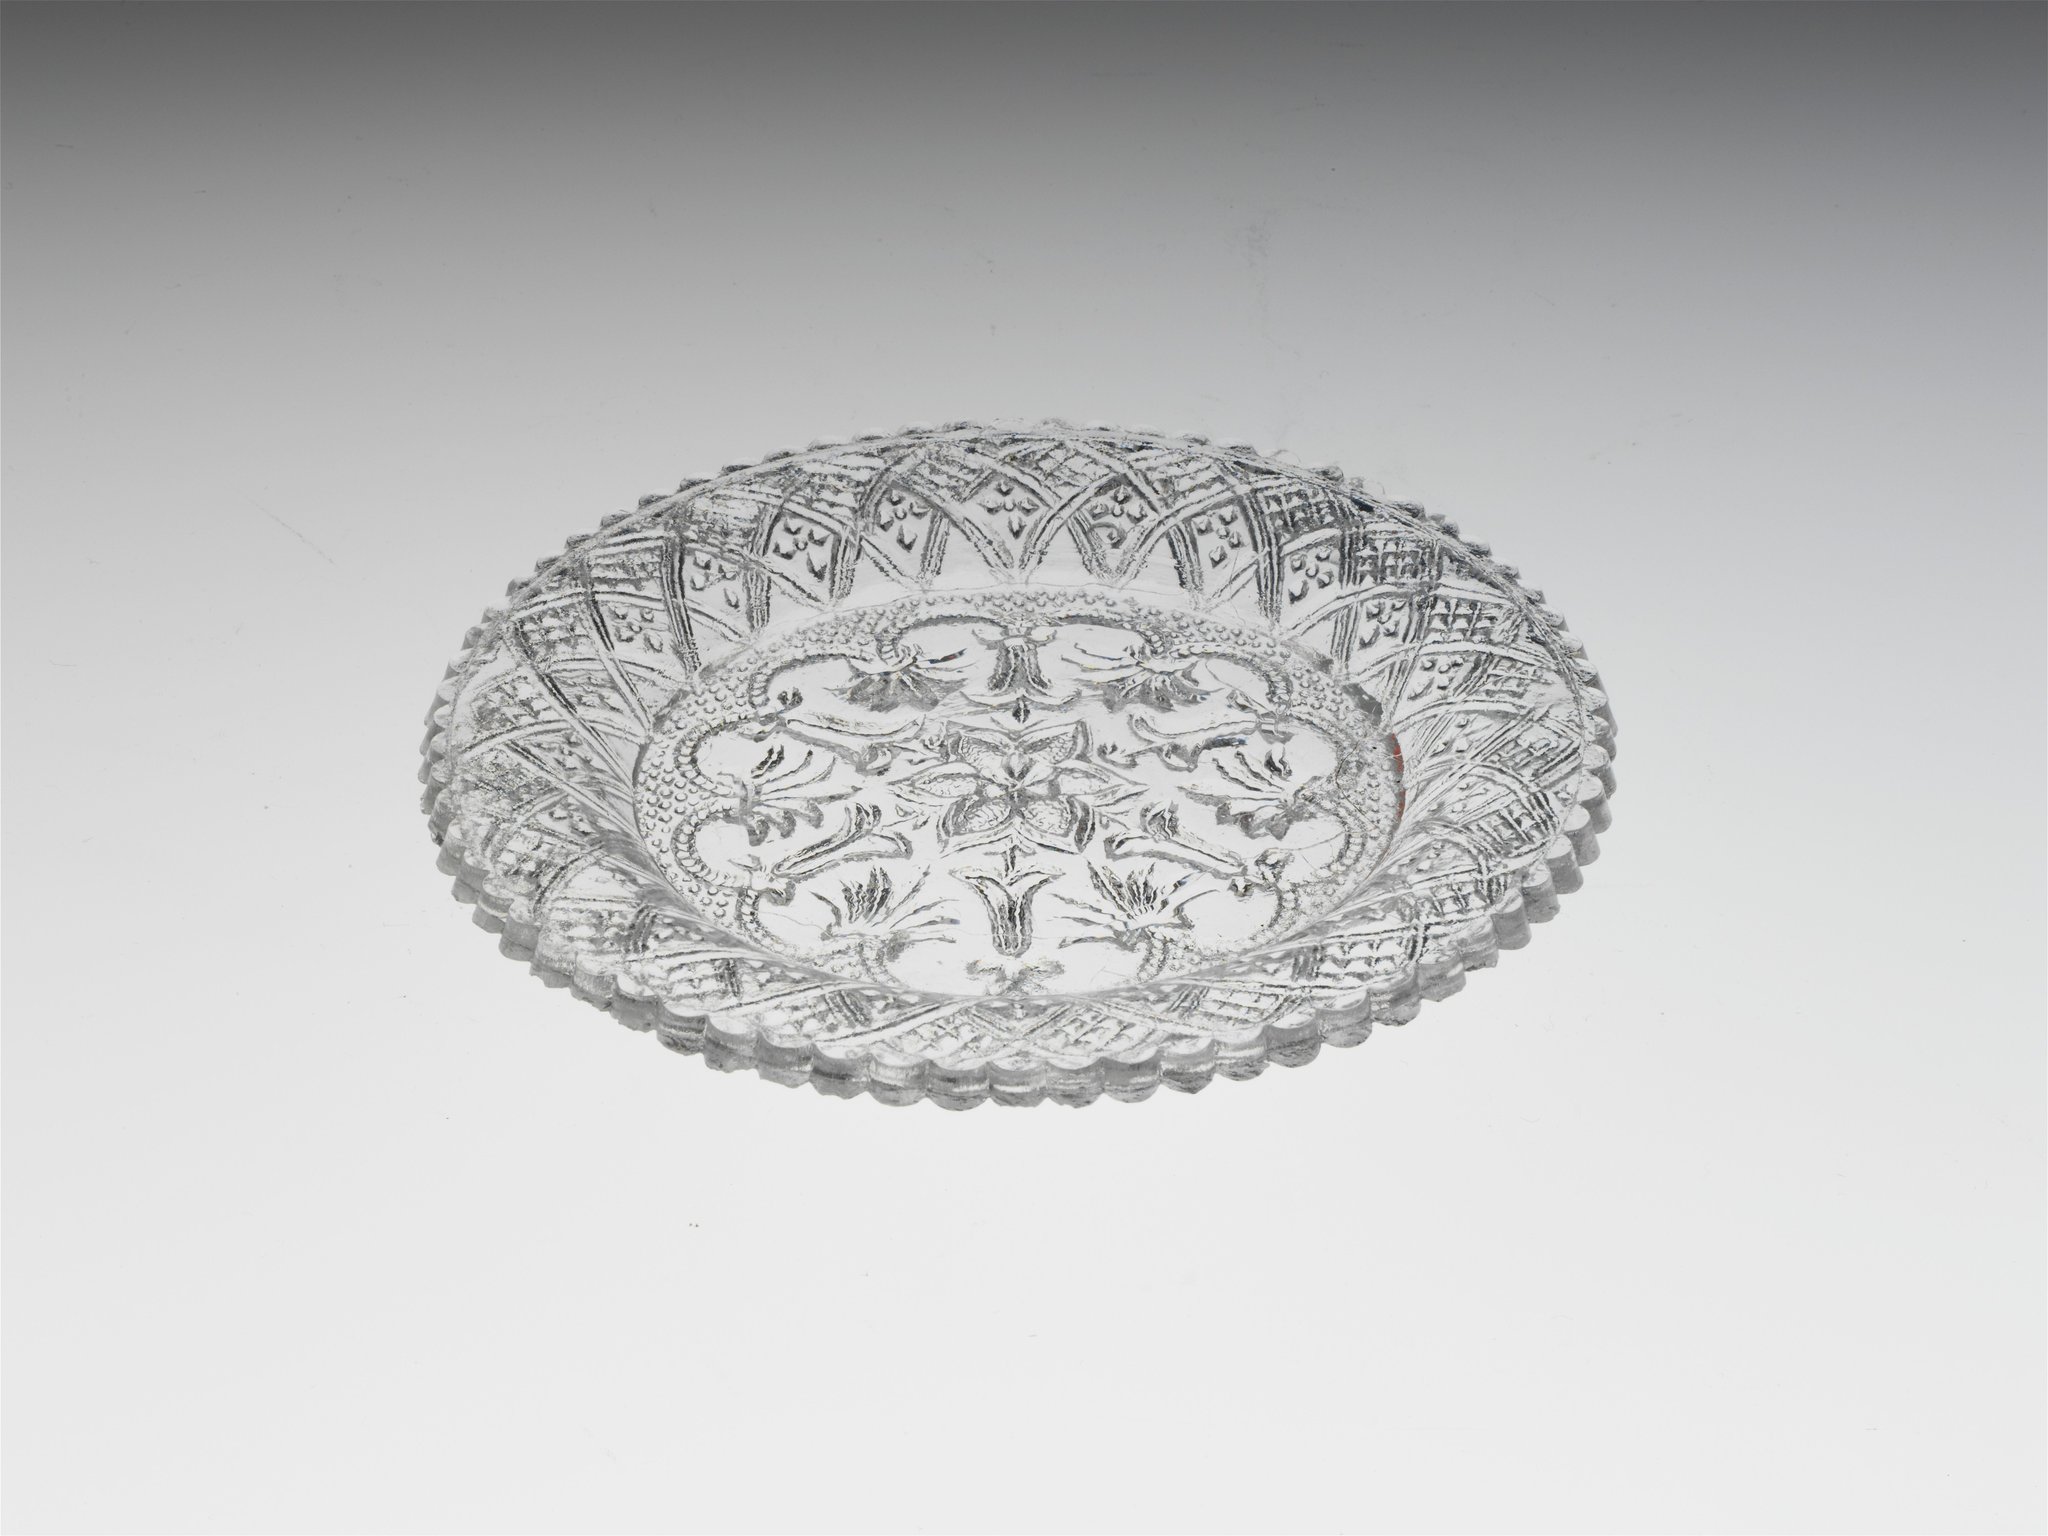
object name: cup plate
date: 1825-1860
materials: glass